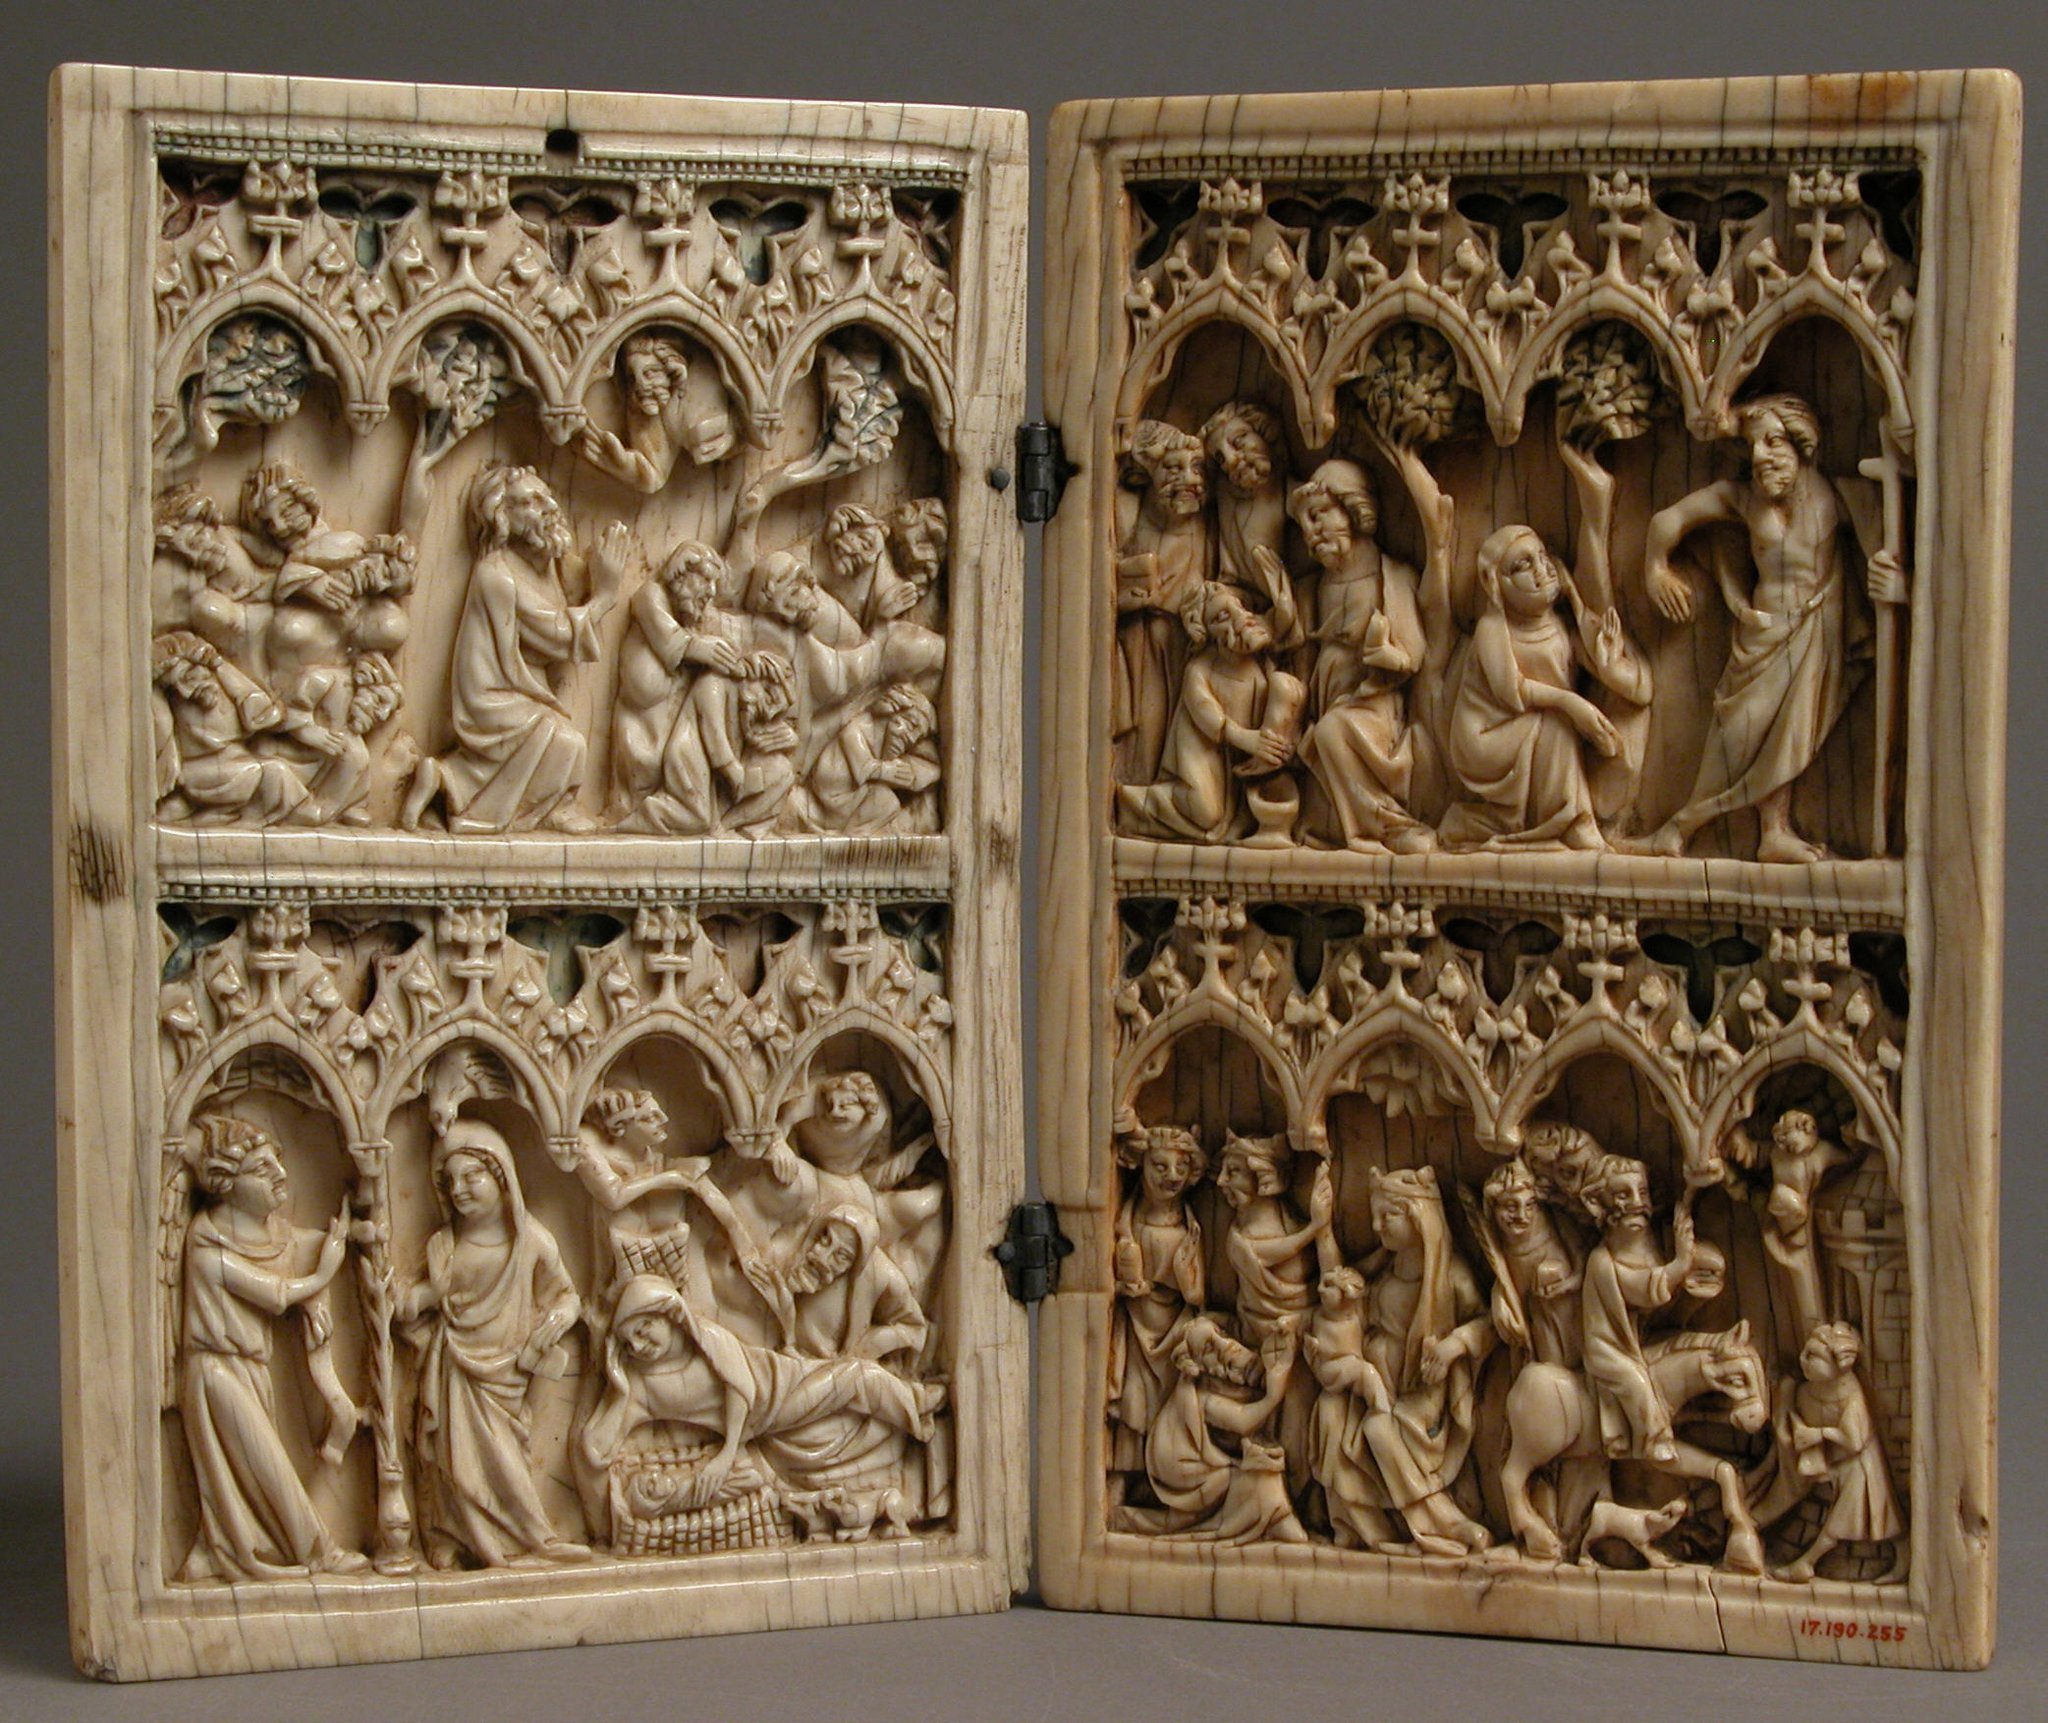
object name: diptych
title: Diptych with Scenes from the Life of Christ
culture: french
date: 1301-1400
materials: ivory, metal, paint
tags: angels,christ,virgin mary,adoration of the magi,adoration of the shepherds,annunciation,nativity